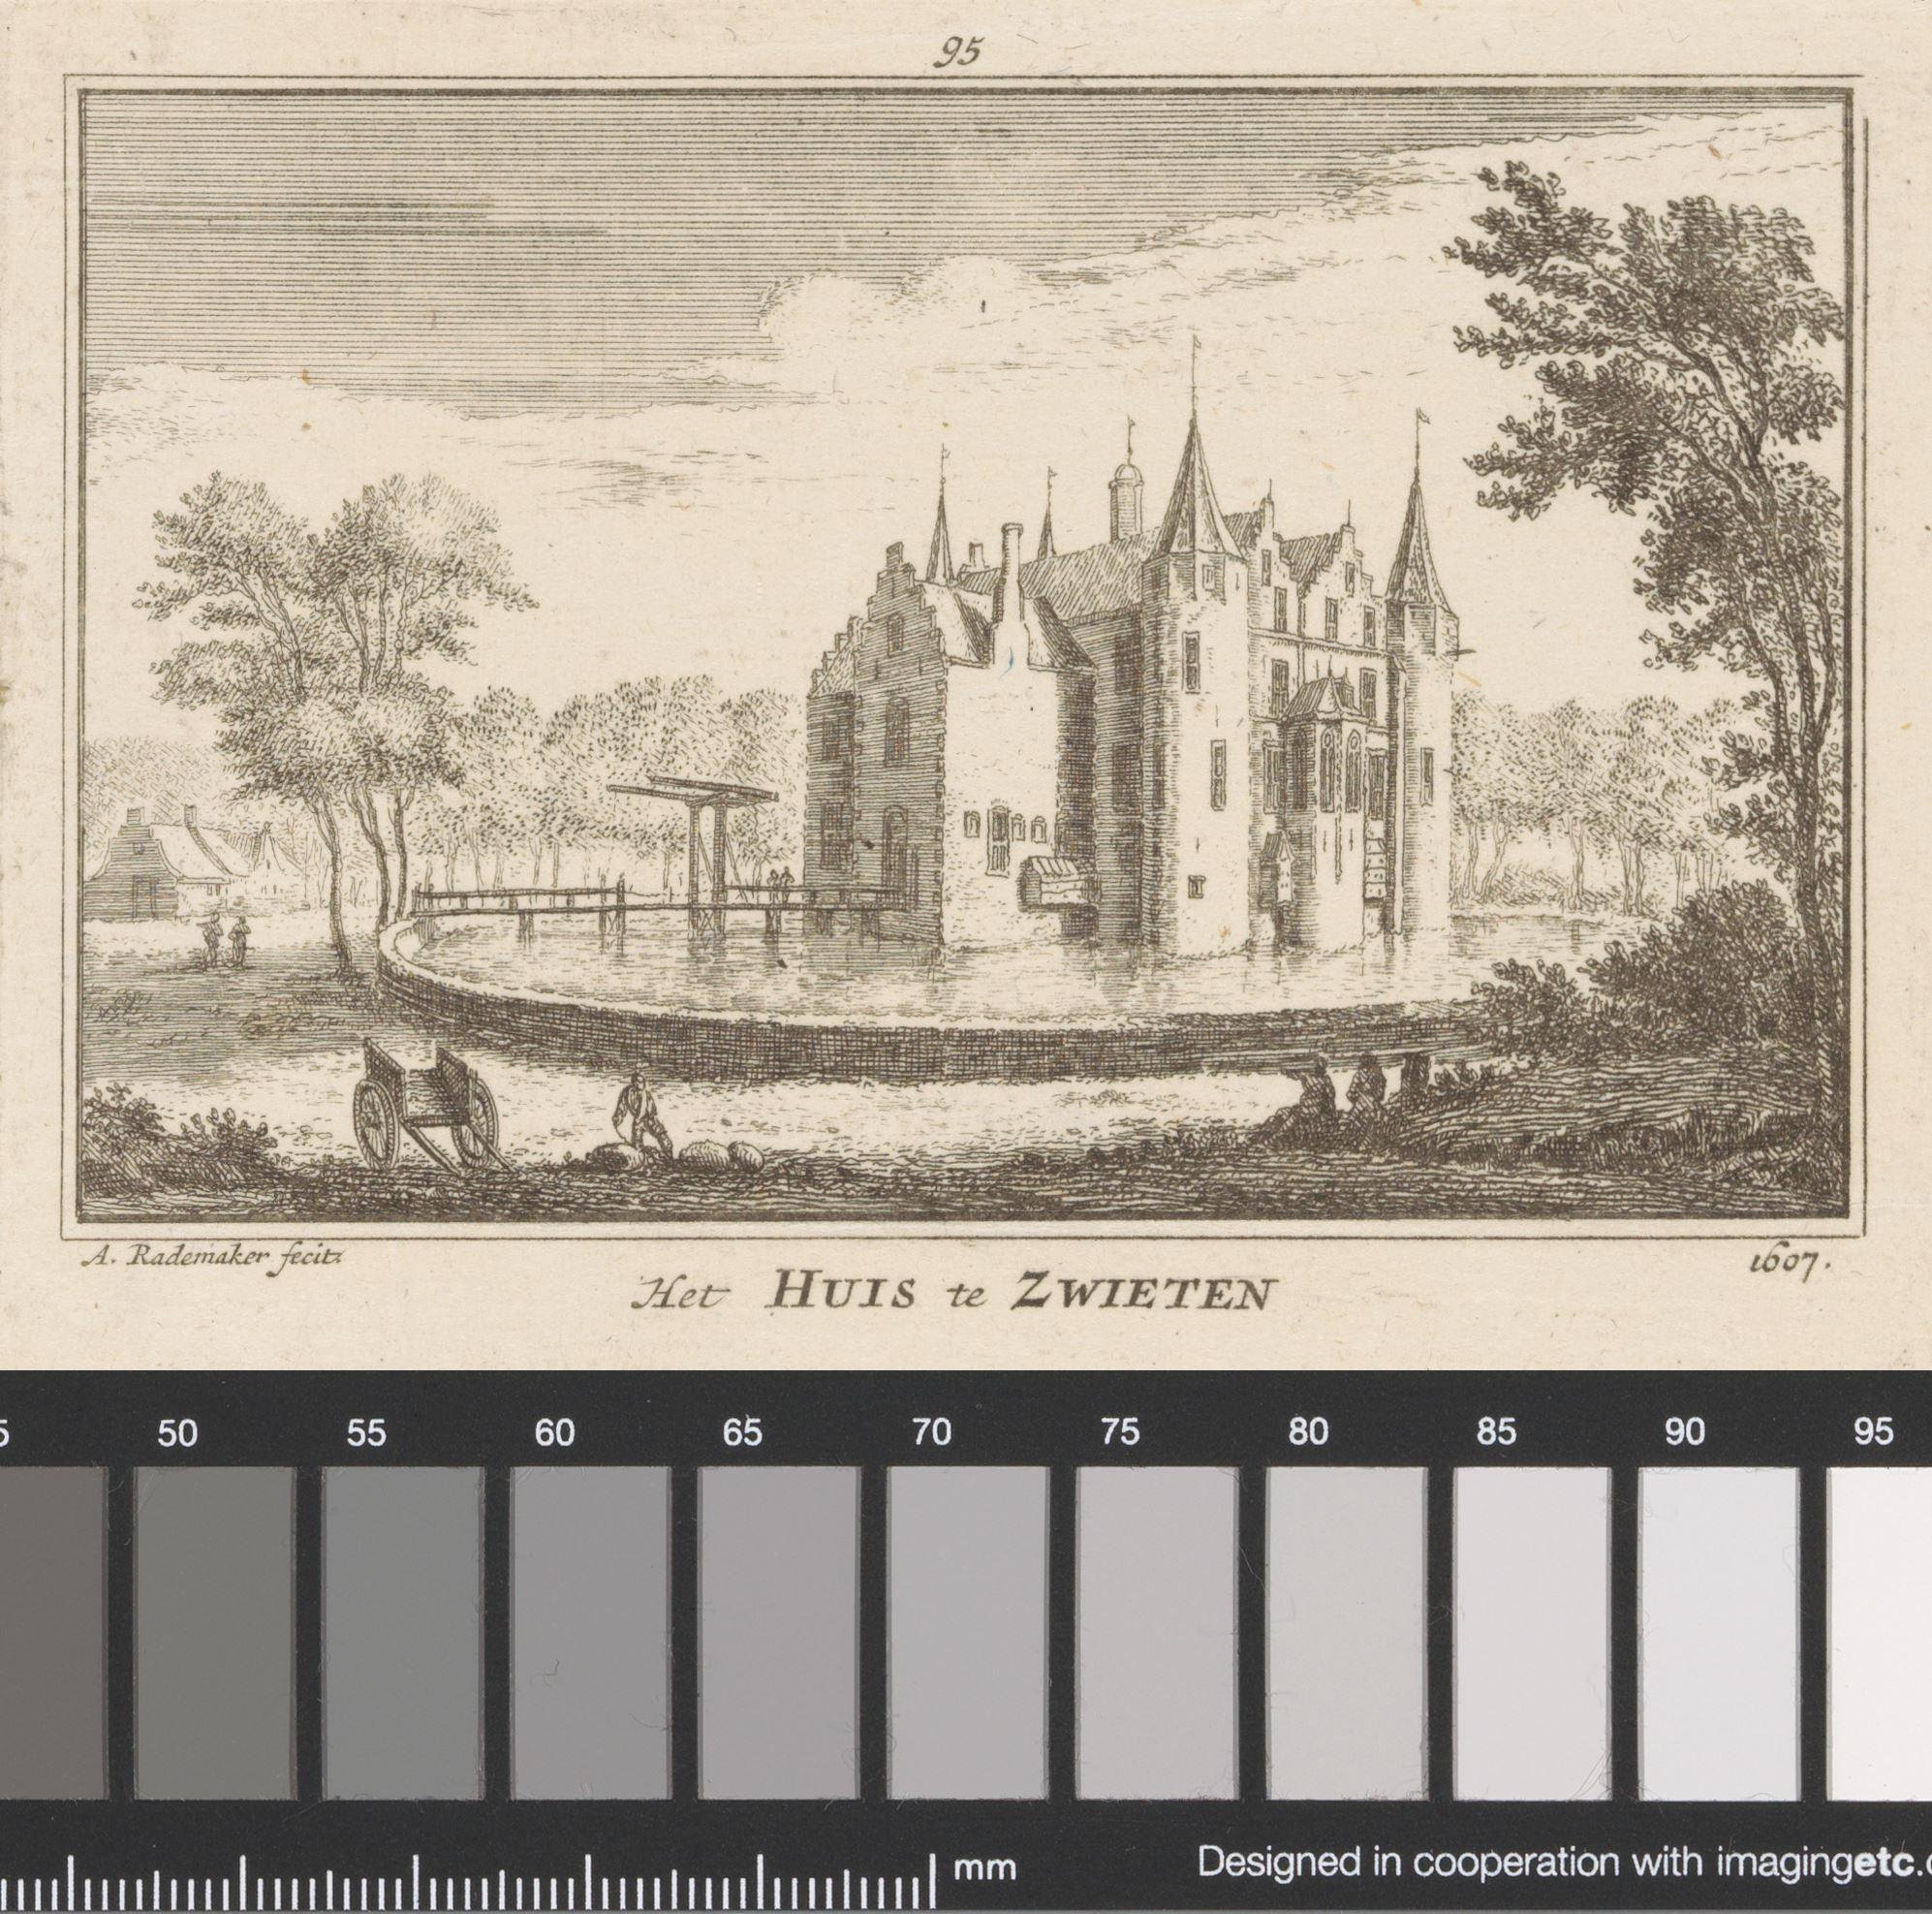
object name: book illustration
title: Gezicht op Huis te Swieten, 1607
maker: abraham rademaker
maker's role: draughtsman, print maker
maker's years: 1676-1735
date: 1725-1803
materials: paper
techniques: engraving, etching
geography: amsterdam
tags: castle, bridge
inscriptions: collector's mark: Lugt 2228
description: Prent ook gebruikt in: Rademaker, Abraham. Kabinet van Nederlandsche outheden en gezichten: vervat in 300 konstplaaten (…). 2 delen. Amsterdam: Willem Barents, 1725, dl. 1, ill. 95. Na 1725 is deze prent nog in verschillende heruitgaven verschenen, uitgegeven in 1727-1733, 1770-1771 en 1792-1803. Uit welke uitgave het huidige exemplaar precies komt is niet na te gaan.